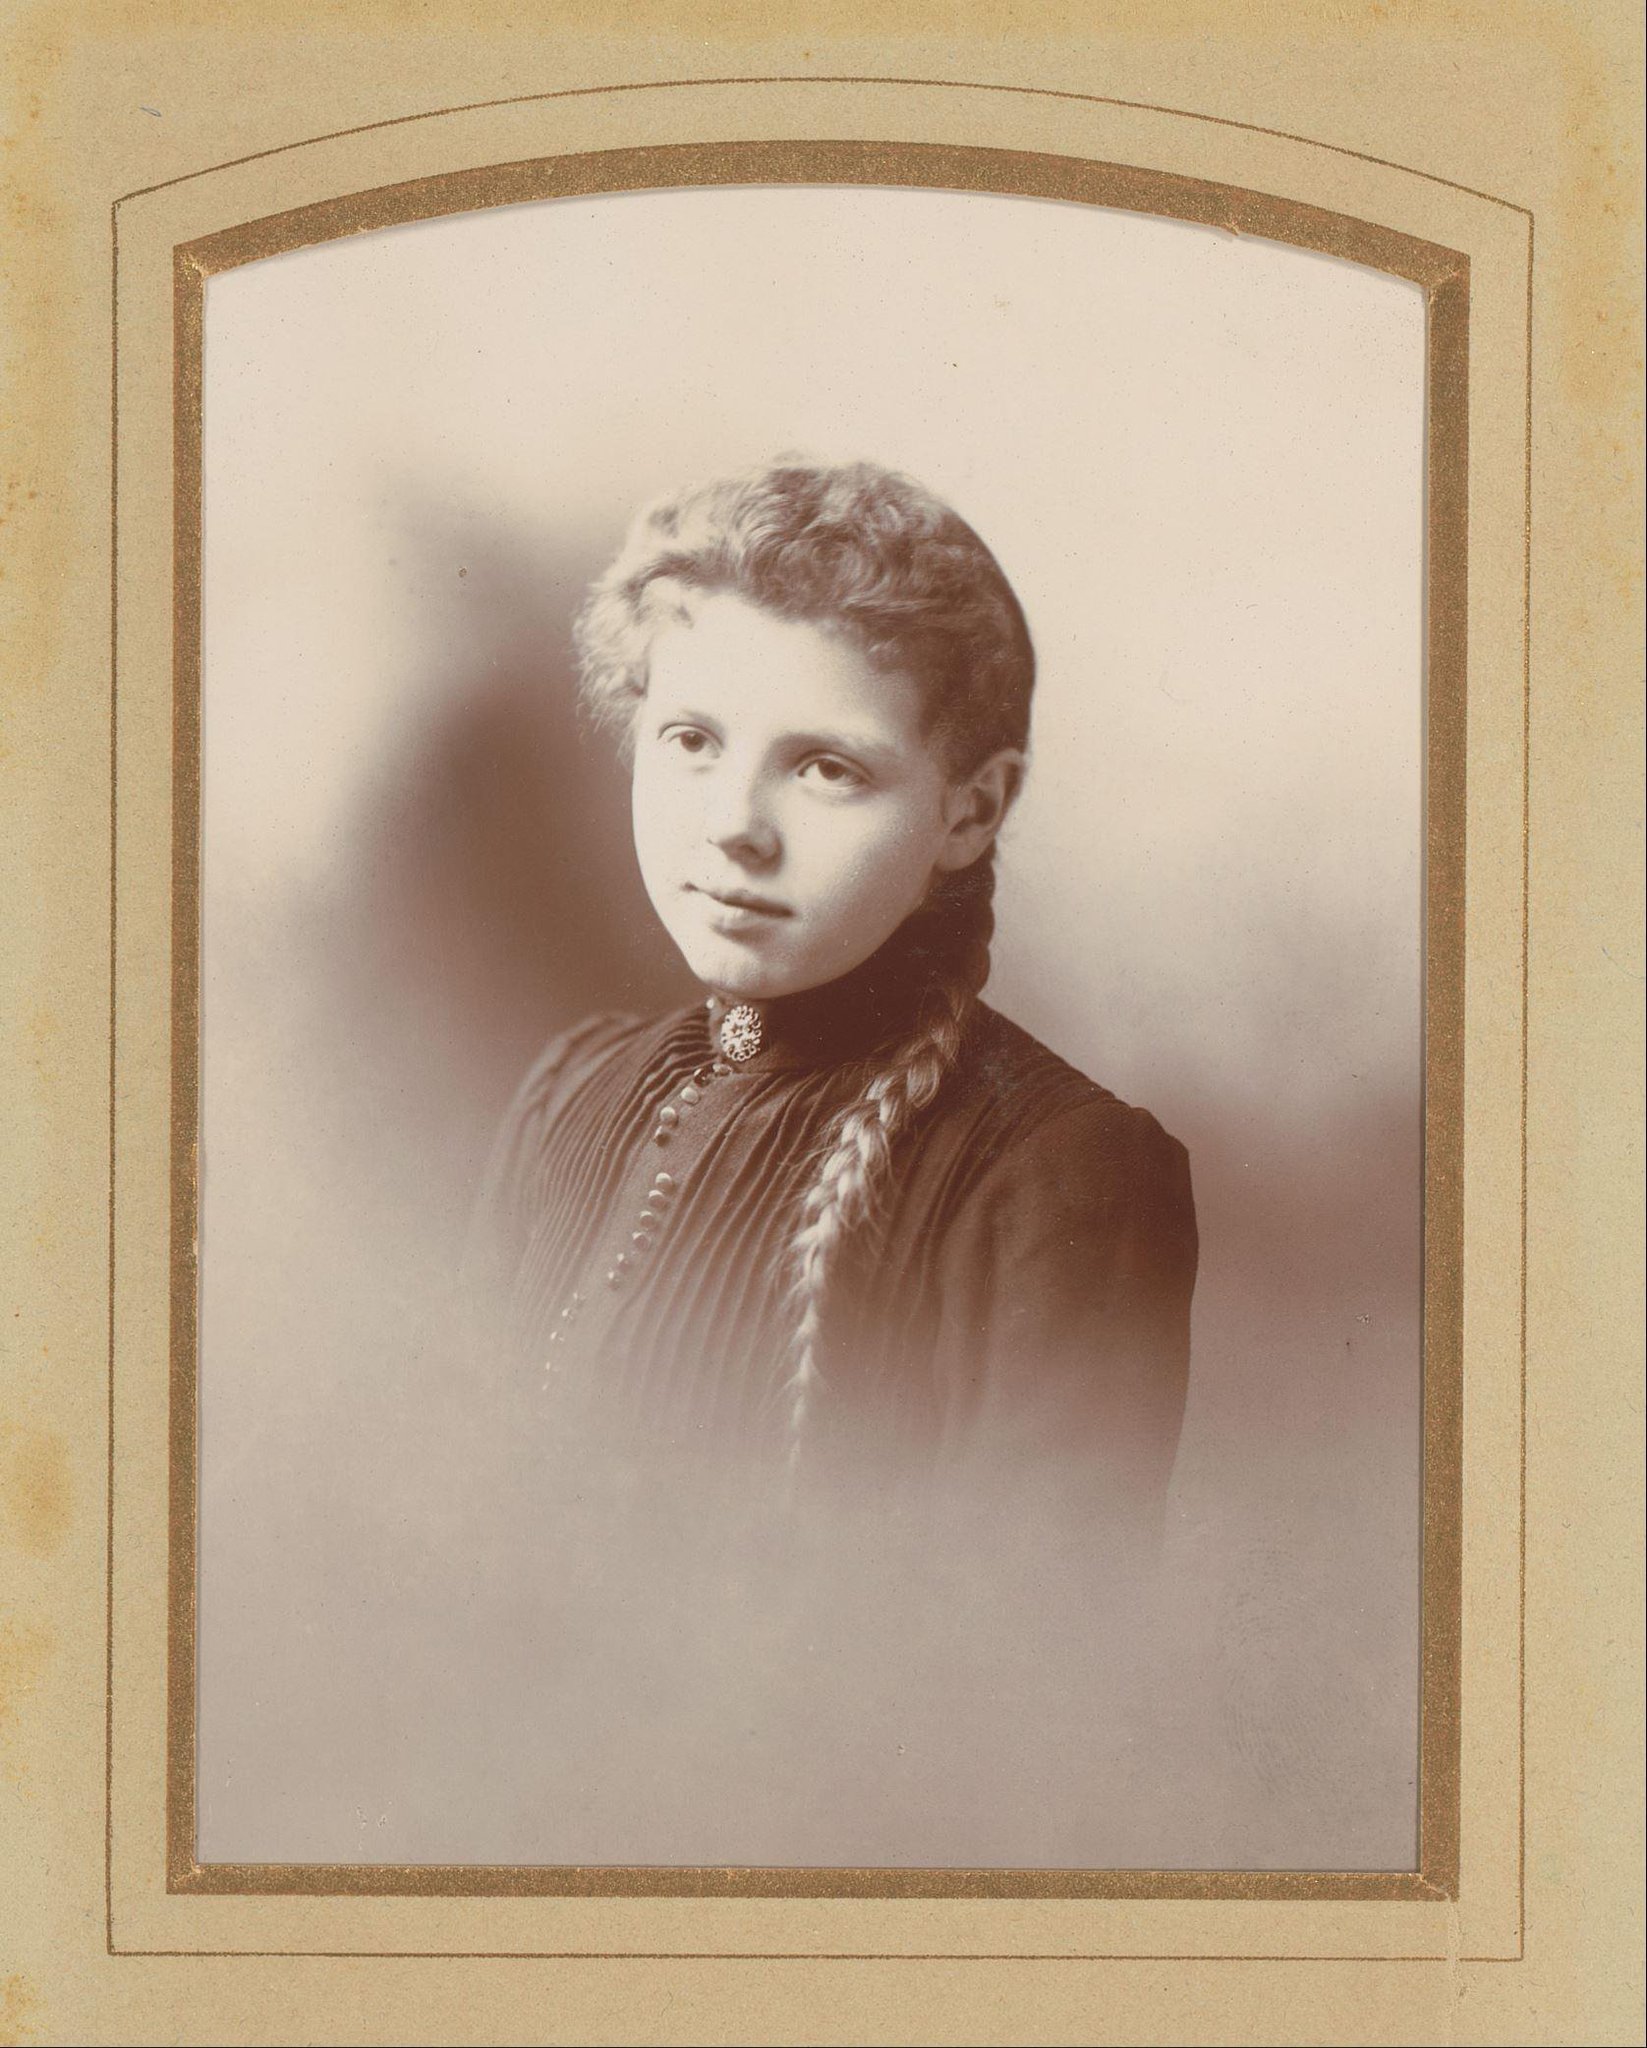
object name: album leaf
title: Portret van een meisje met vlecht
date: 1880-1910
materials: cardboard, photographic support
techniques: daylight paper print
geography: chicago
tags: girl (child between toddler and youth)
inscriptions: inscription: ‘The R & R Photostudio/ C. Holdmann, Mgr./ Atwood Bldg./ Clark and Madison Streets/ Chicago’